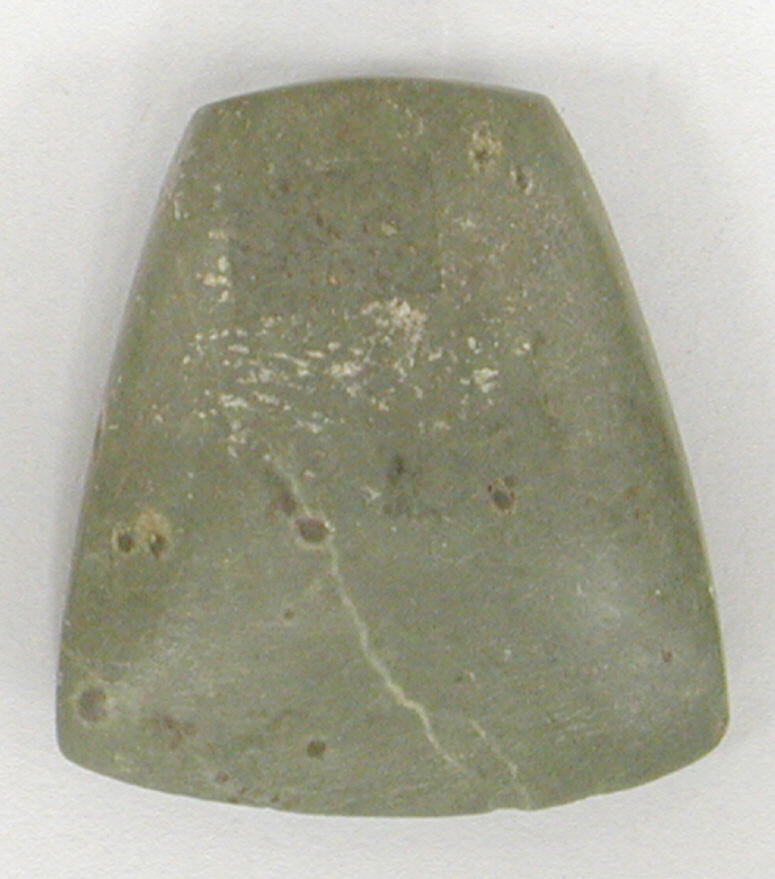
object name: chisel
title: Stone Chisel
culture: mexican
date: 1501-1600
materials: stone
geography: mexico